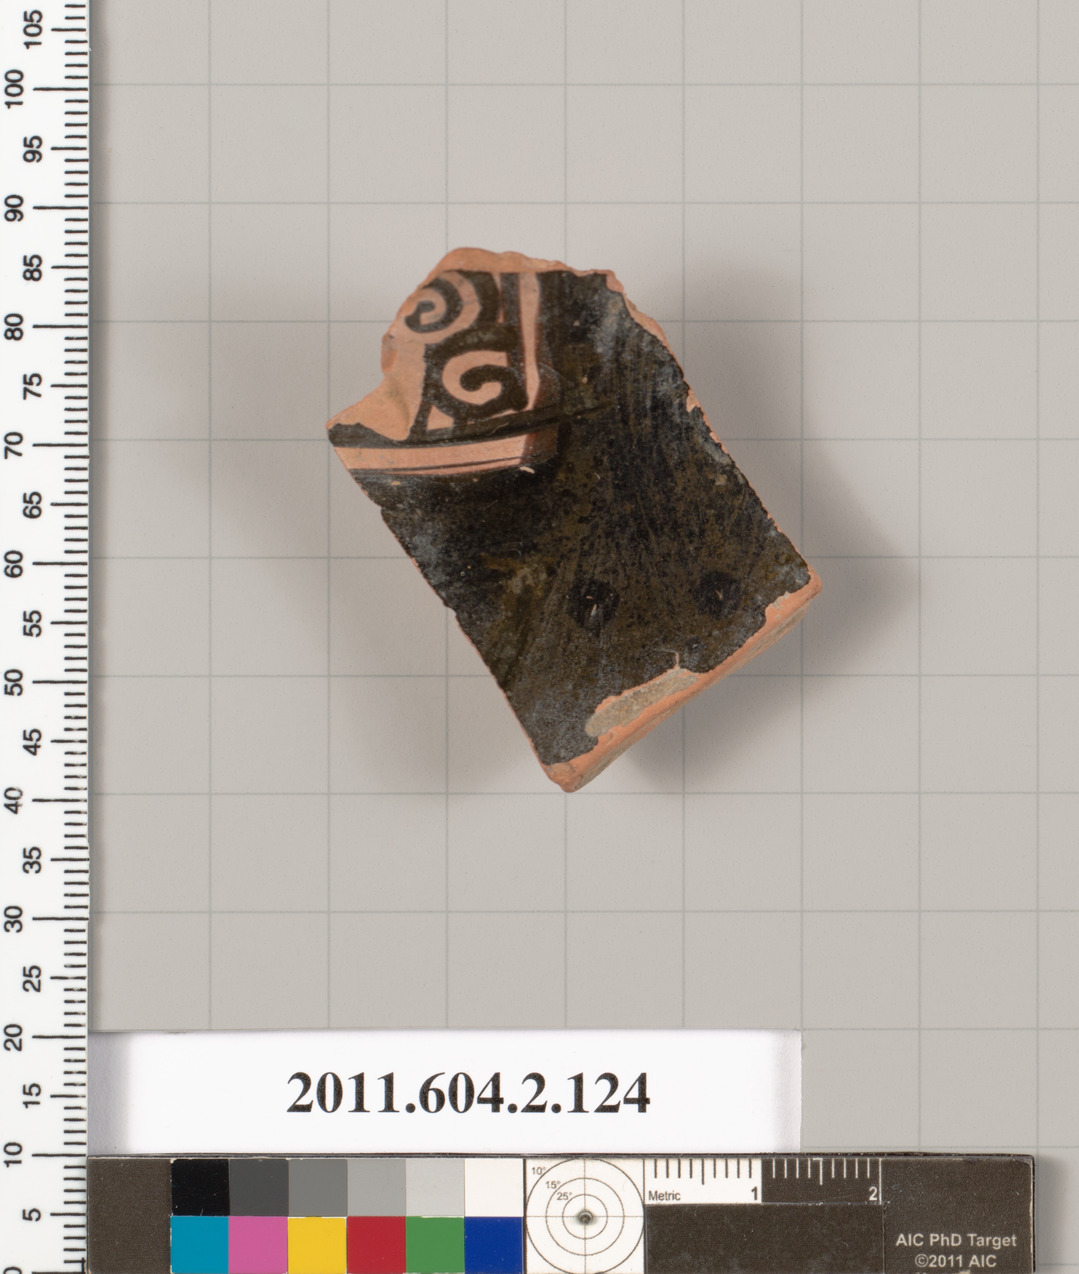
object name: pelike fragment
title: Terracotta fragment of a pelike (jar)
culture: greek, attic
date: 460-440 BCE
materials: terracotta